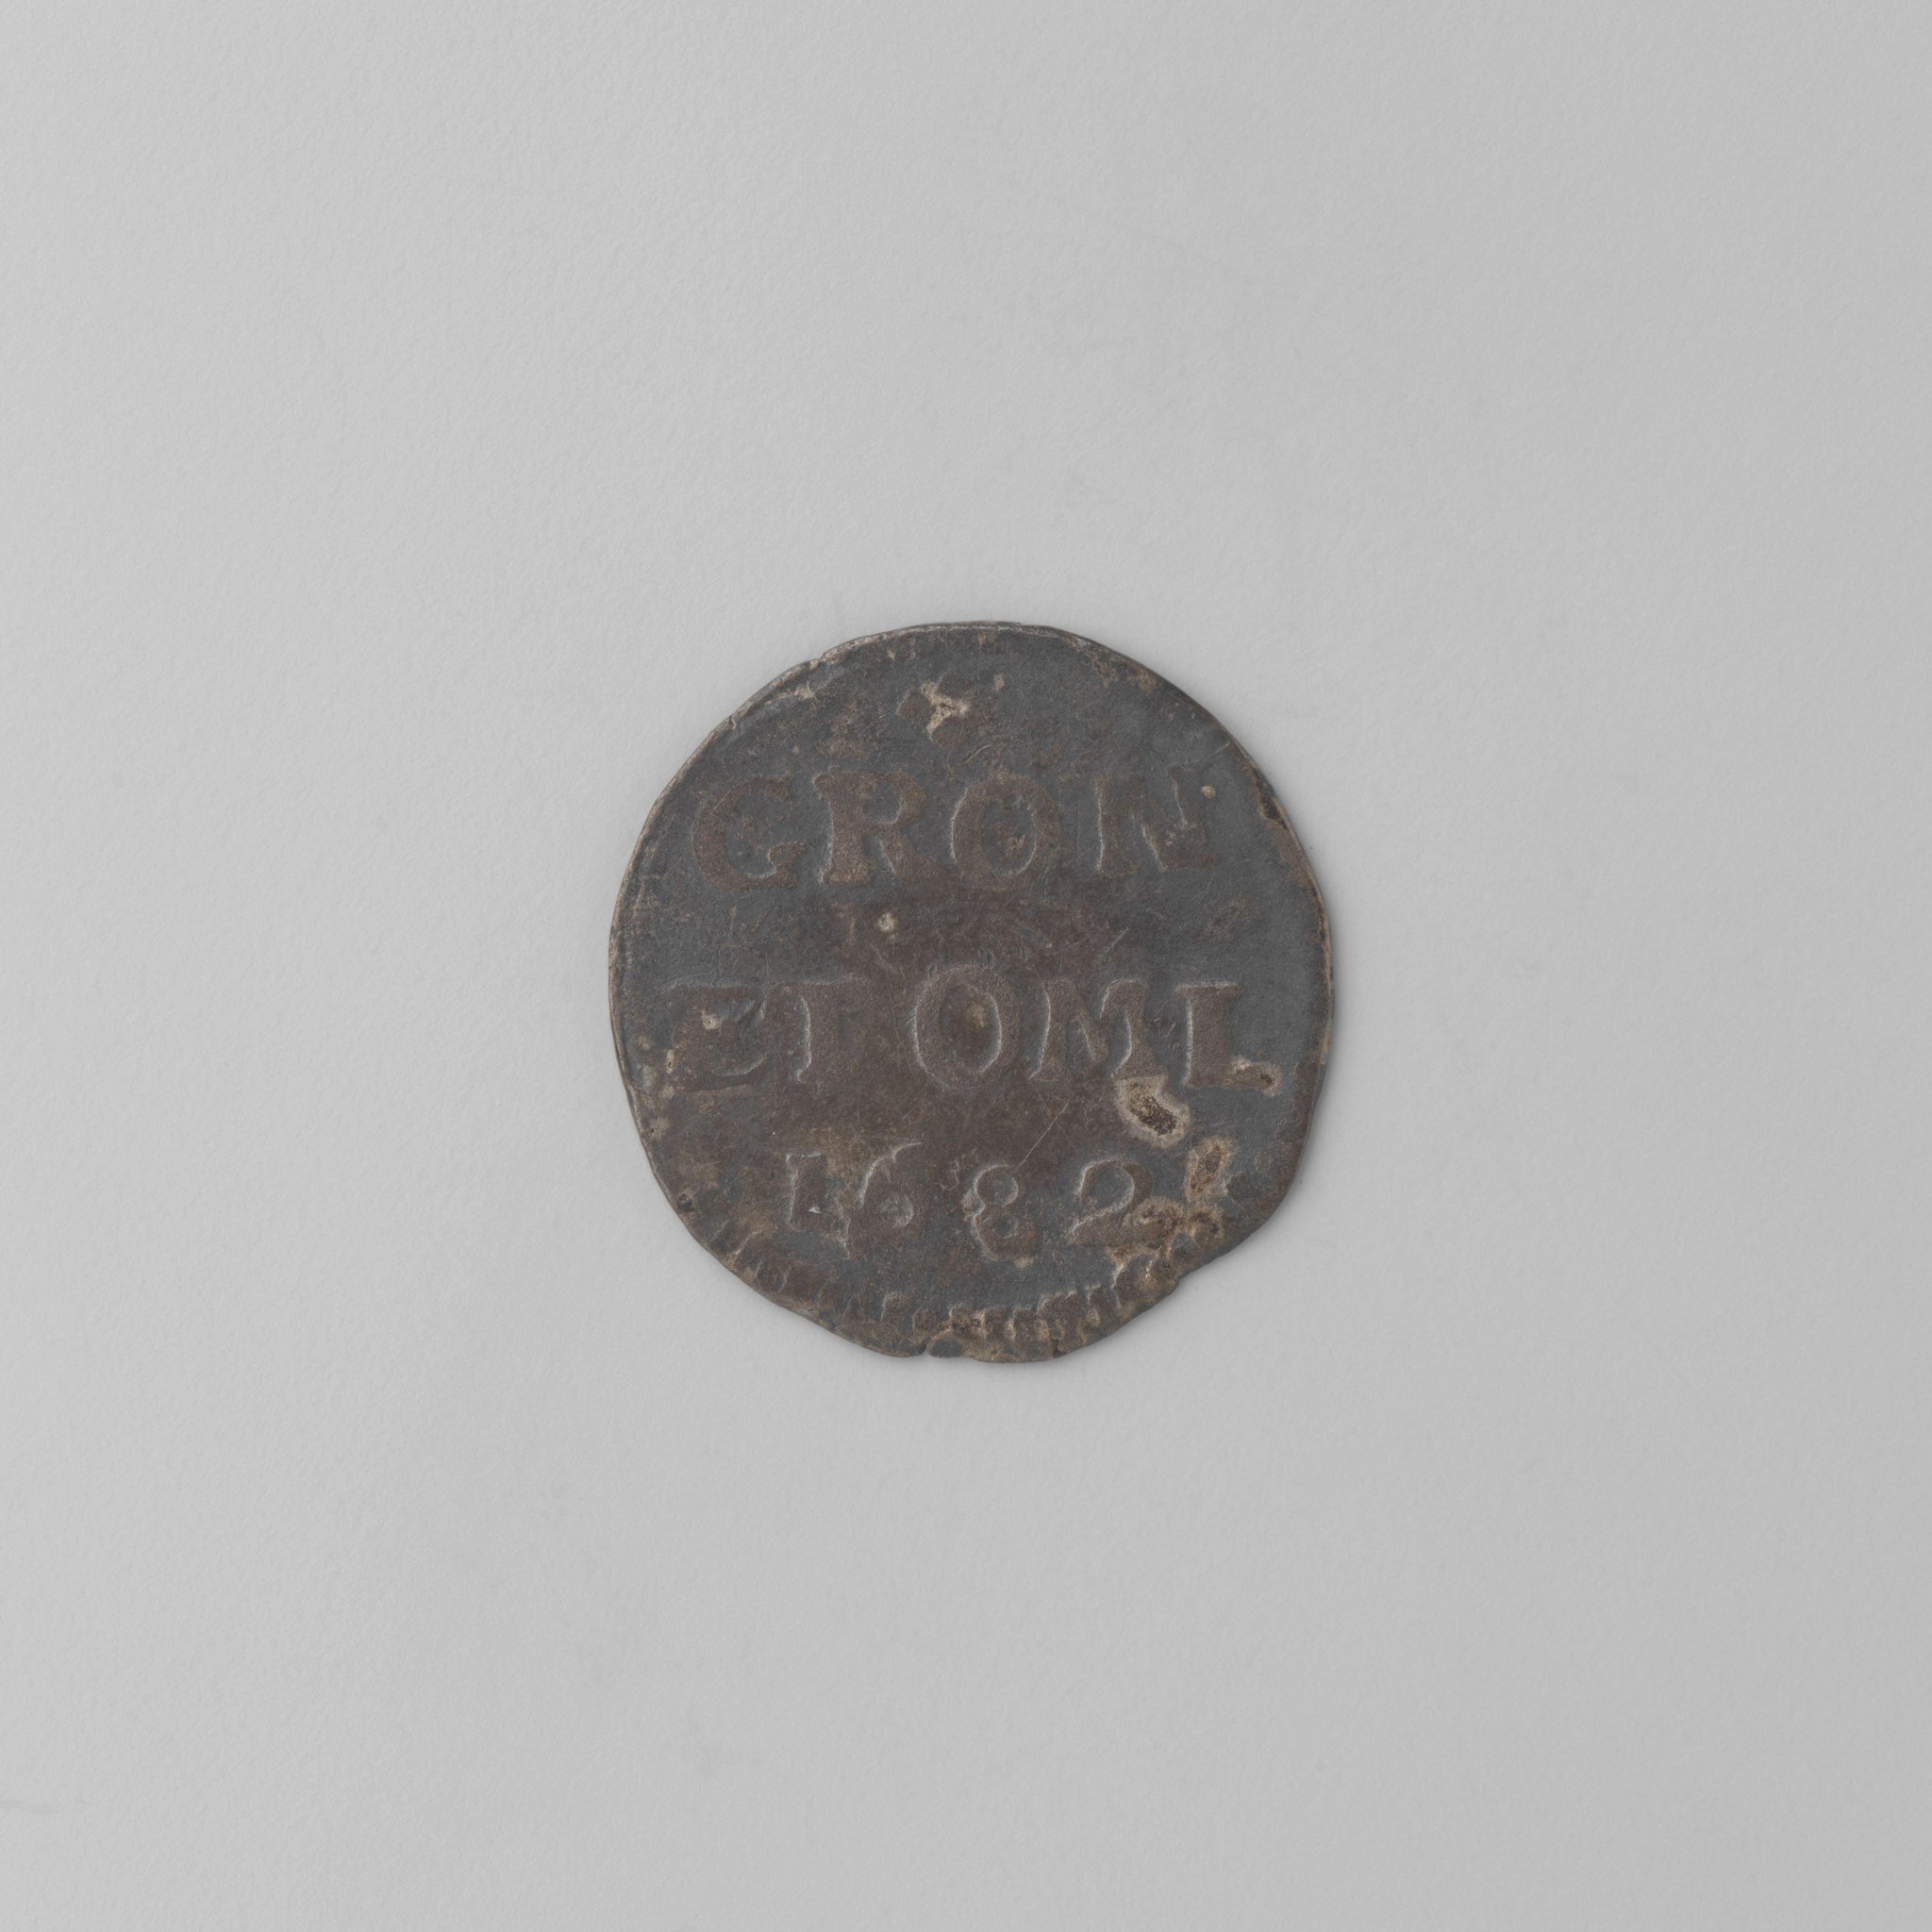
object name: coin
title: Stuiver van Groningen en de Ommelanden, 1682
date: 1682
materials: silver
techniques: striking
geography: groningen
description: Zilveren munt. Voorzijde: tussen waarde-aanduiding 1 S gekrooond wapenschild. Keerzijde: twee-regelig opschrift, waaronder jaartal.